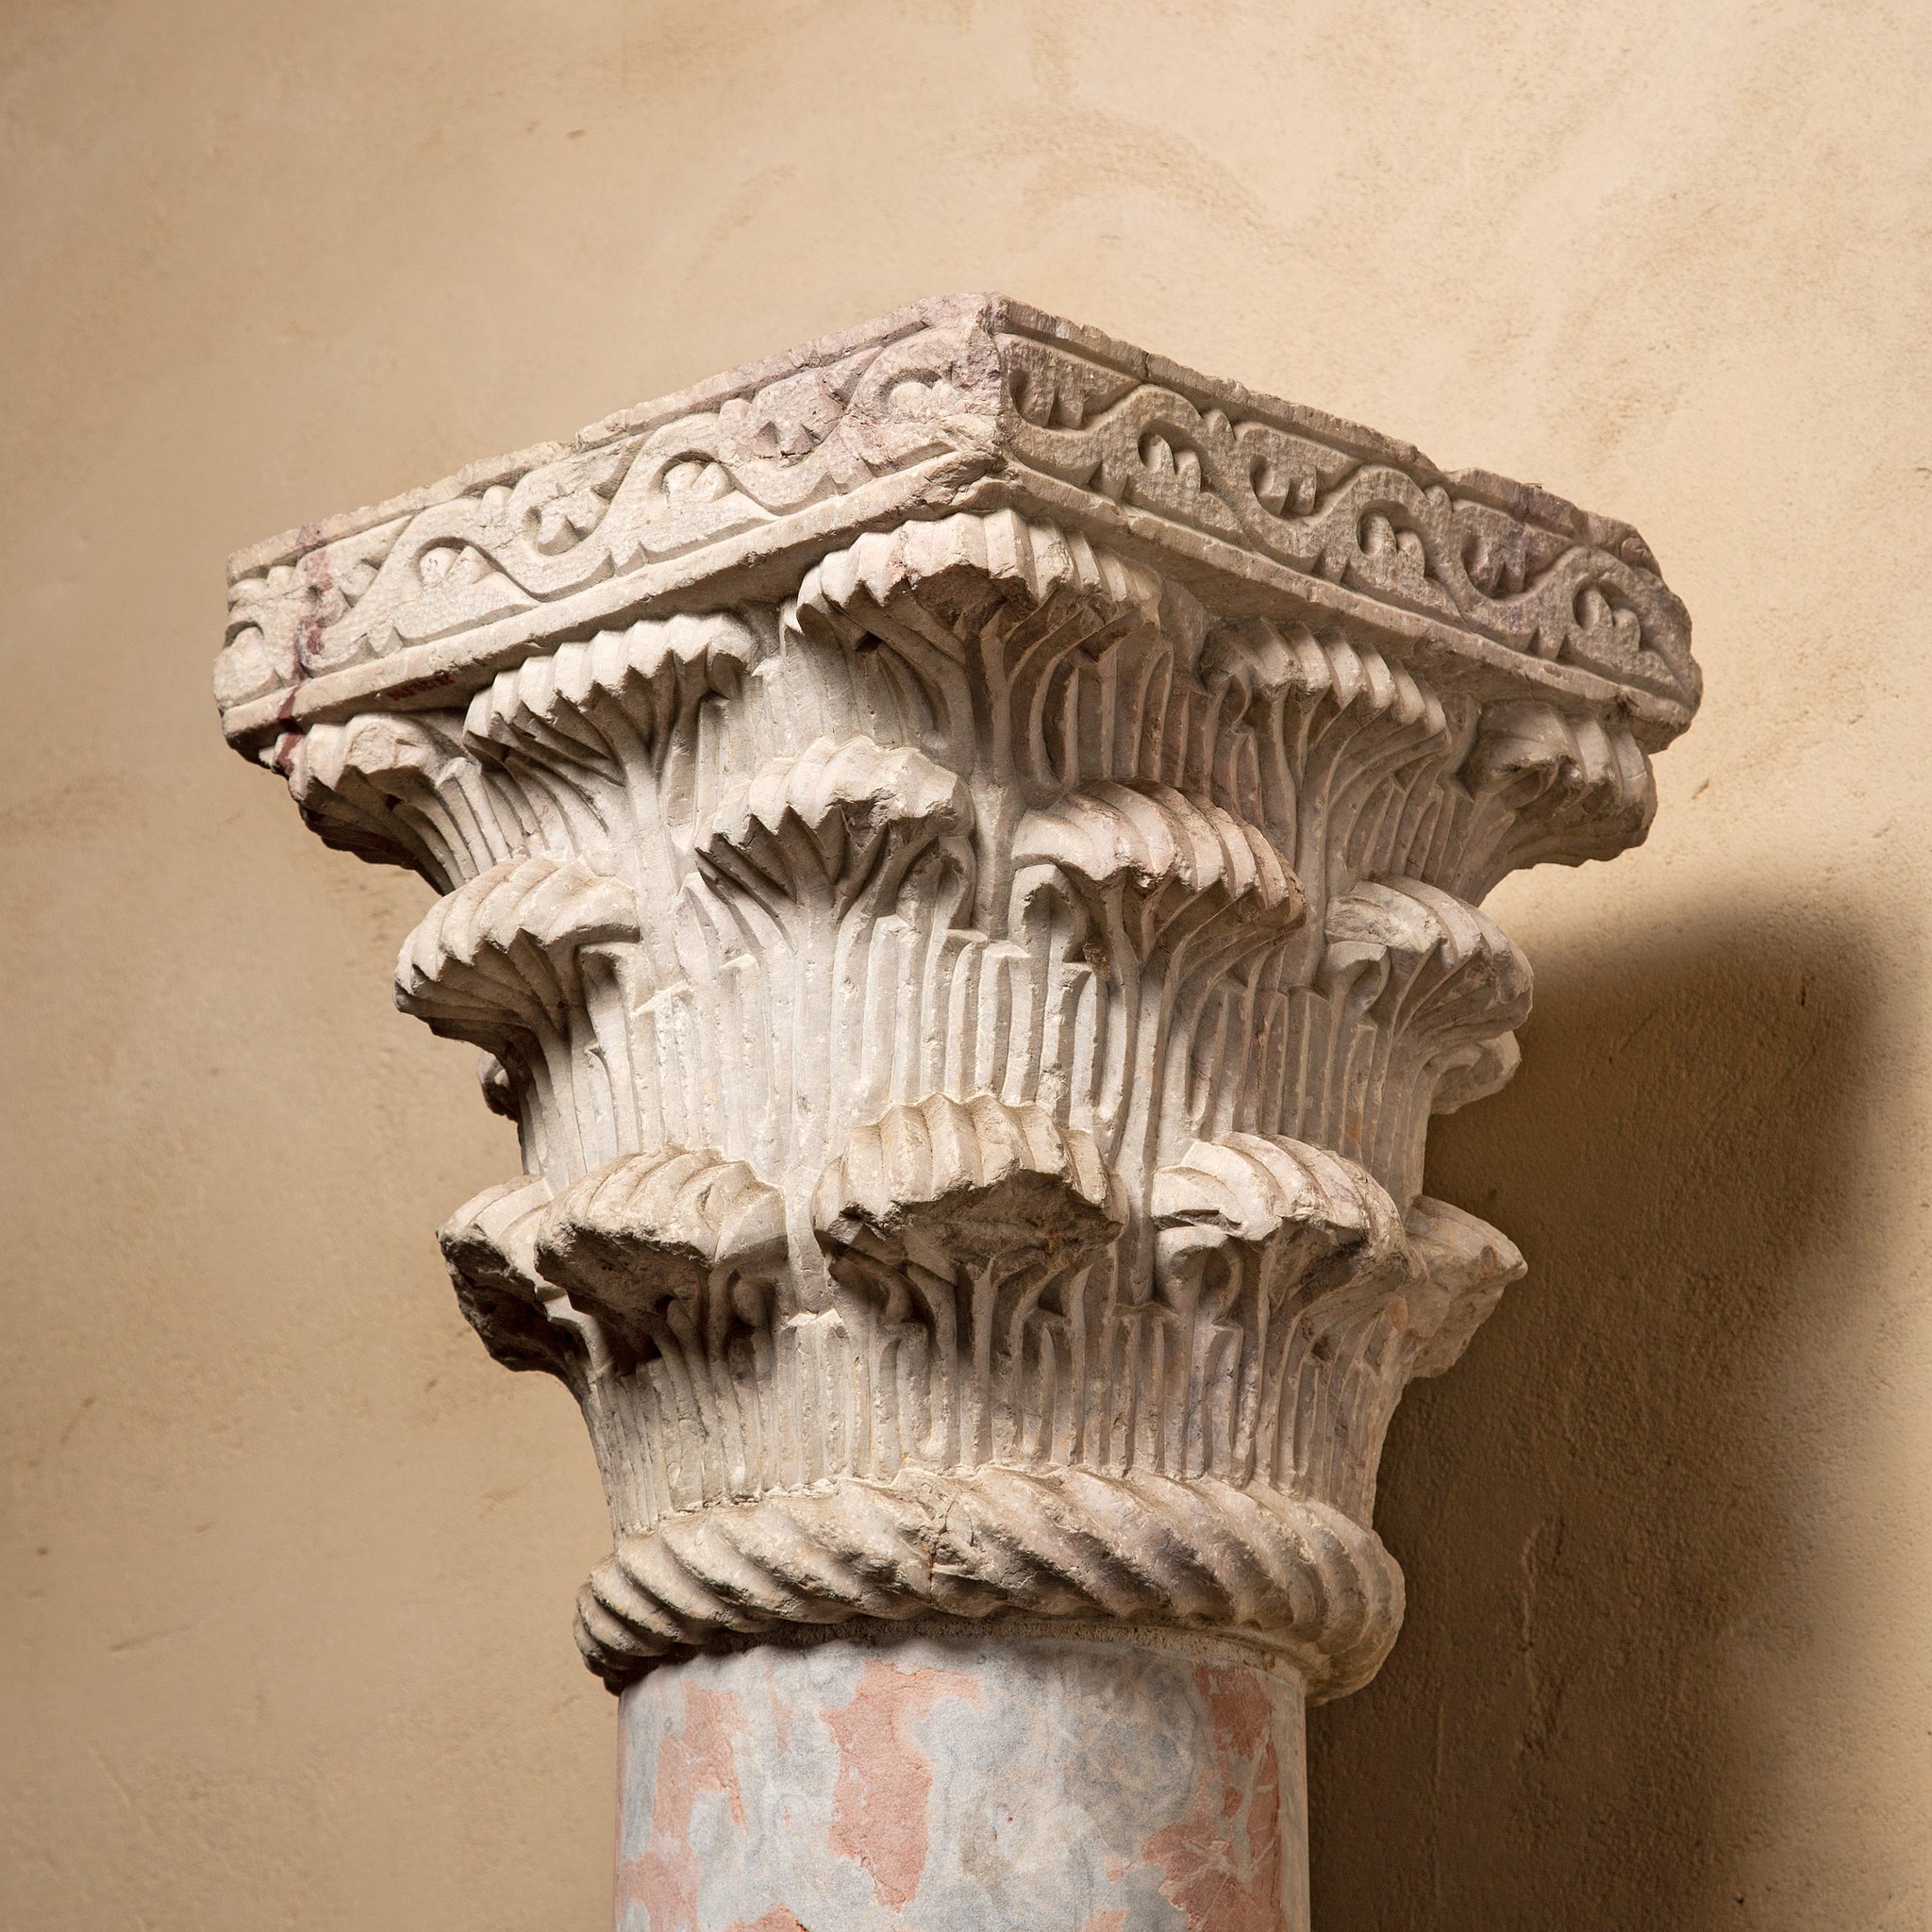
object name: capital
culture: catalan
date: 1130-1140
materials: marble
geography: france